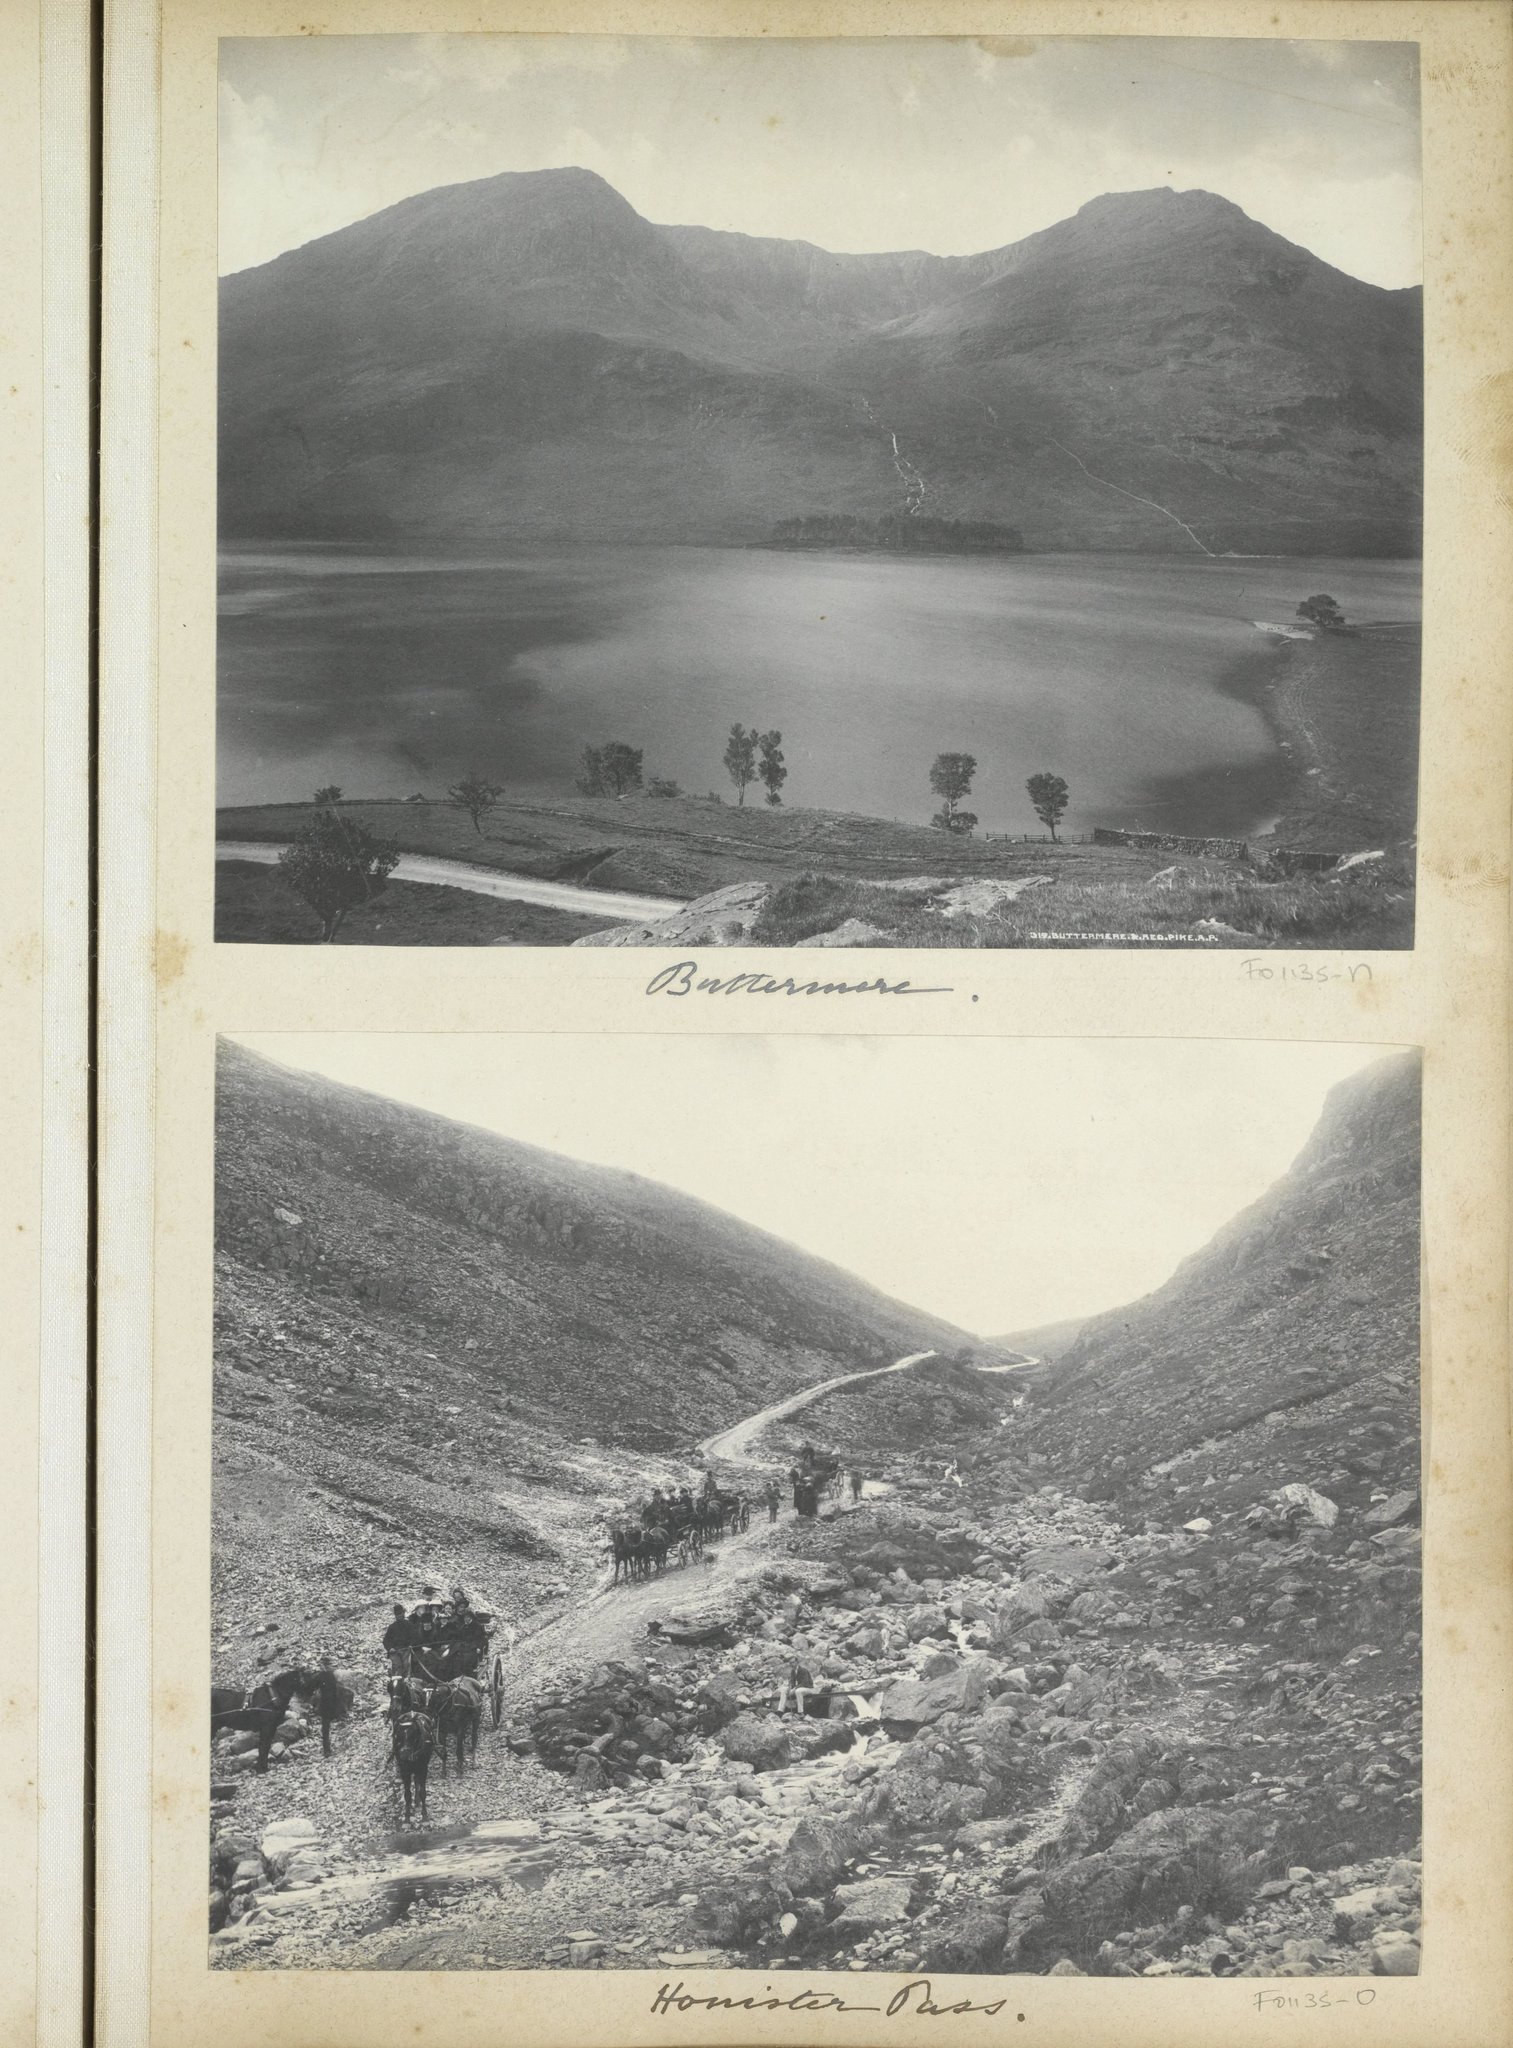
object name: album leaf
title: Buttermere & Red. Pike. A.P.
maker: monogrammist ap (fotograaf)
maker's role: fotograaf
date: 1898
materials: paper, photographic support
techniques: platinum process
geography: buttermere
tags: mountain-top, peak (+ landscape with figures, staffage), lake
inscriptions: number: ‘319’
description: Onderdeel van Reisalbum met foto's van bezienswaardigheden in Engeland en Frankrijk.